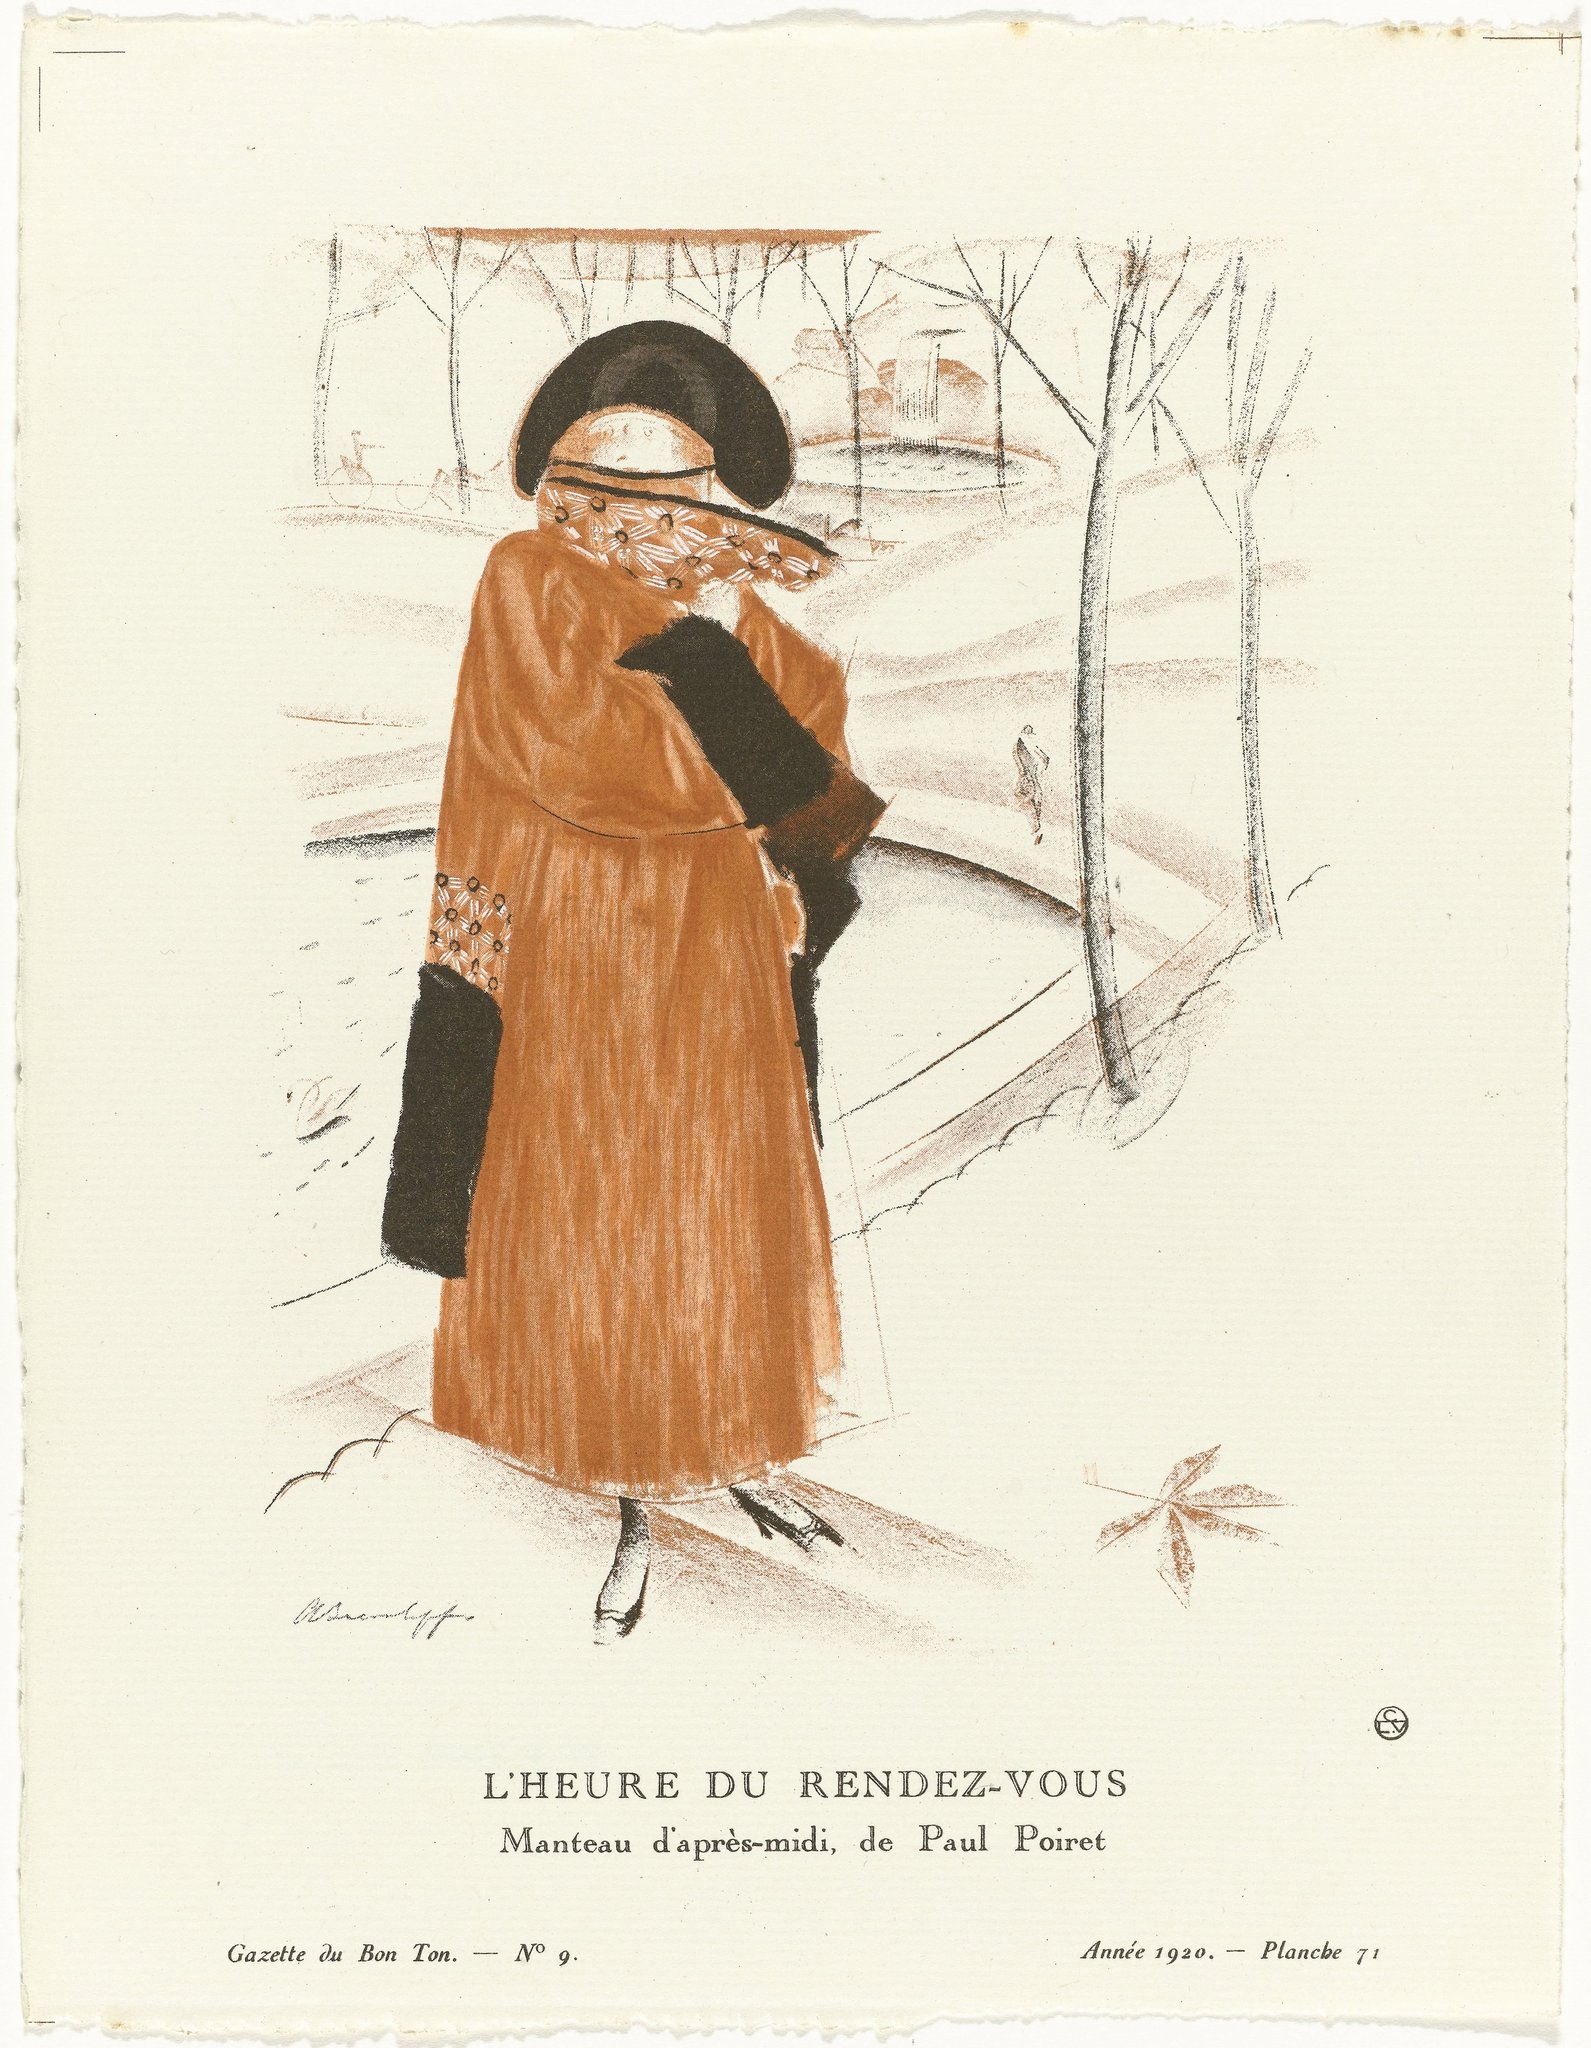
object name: fashion print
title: Gazette du Bon Ton, 1920 , No. 9, Pl. 71: L'Heure du rendez-vous / Manteau d'après-midi, de Paul Poiret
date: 1920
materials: paper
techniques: printing, hand coloring, letterpress printing, photochemical processes, pochoir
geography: new york city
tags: park, coat (+ women's clothes), fashion plates, head-gear: hat (+ women's clothes)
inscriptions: date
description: Vrouw in een lange rode mantel voor de middag, van Paul Poiret, wachtend op de hoek van een straat. Planche 71 uit Gazette du Bon Ton 1920, No. 9. Uitleg over de kleding op pagina "Explication des Planches".